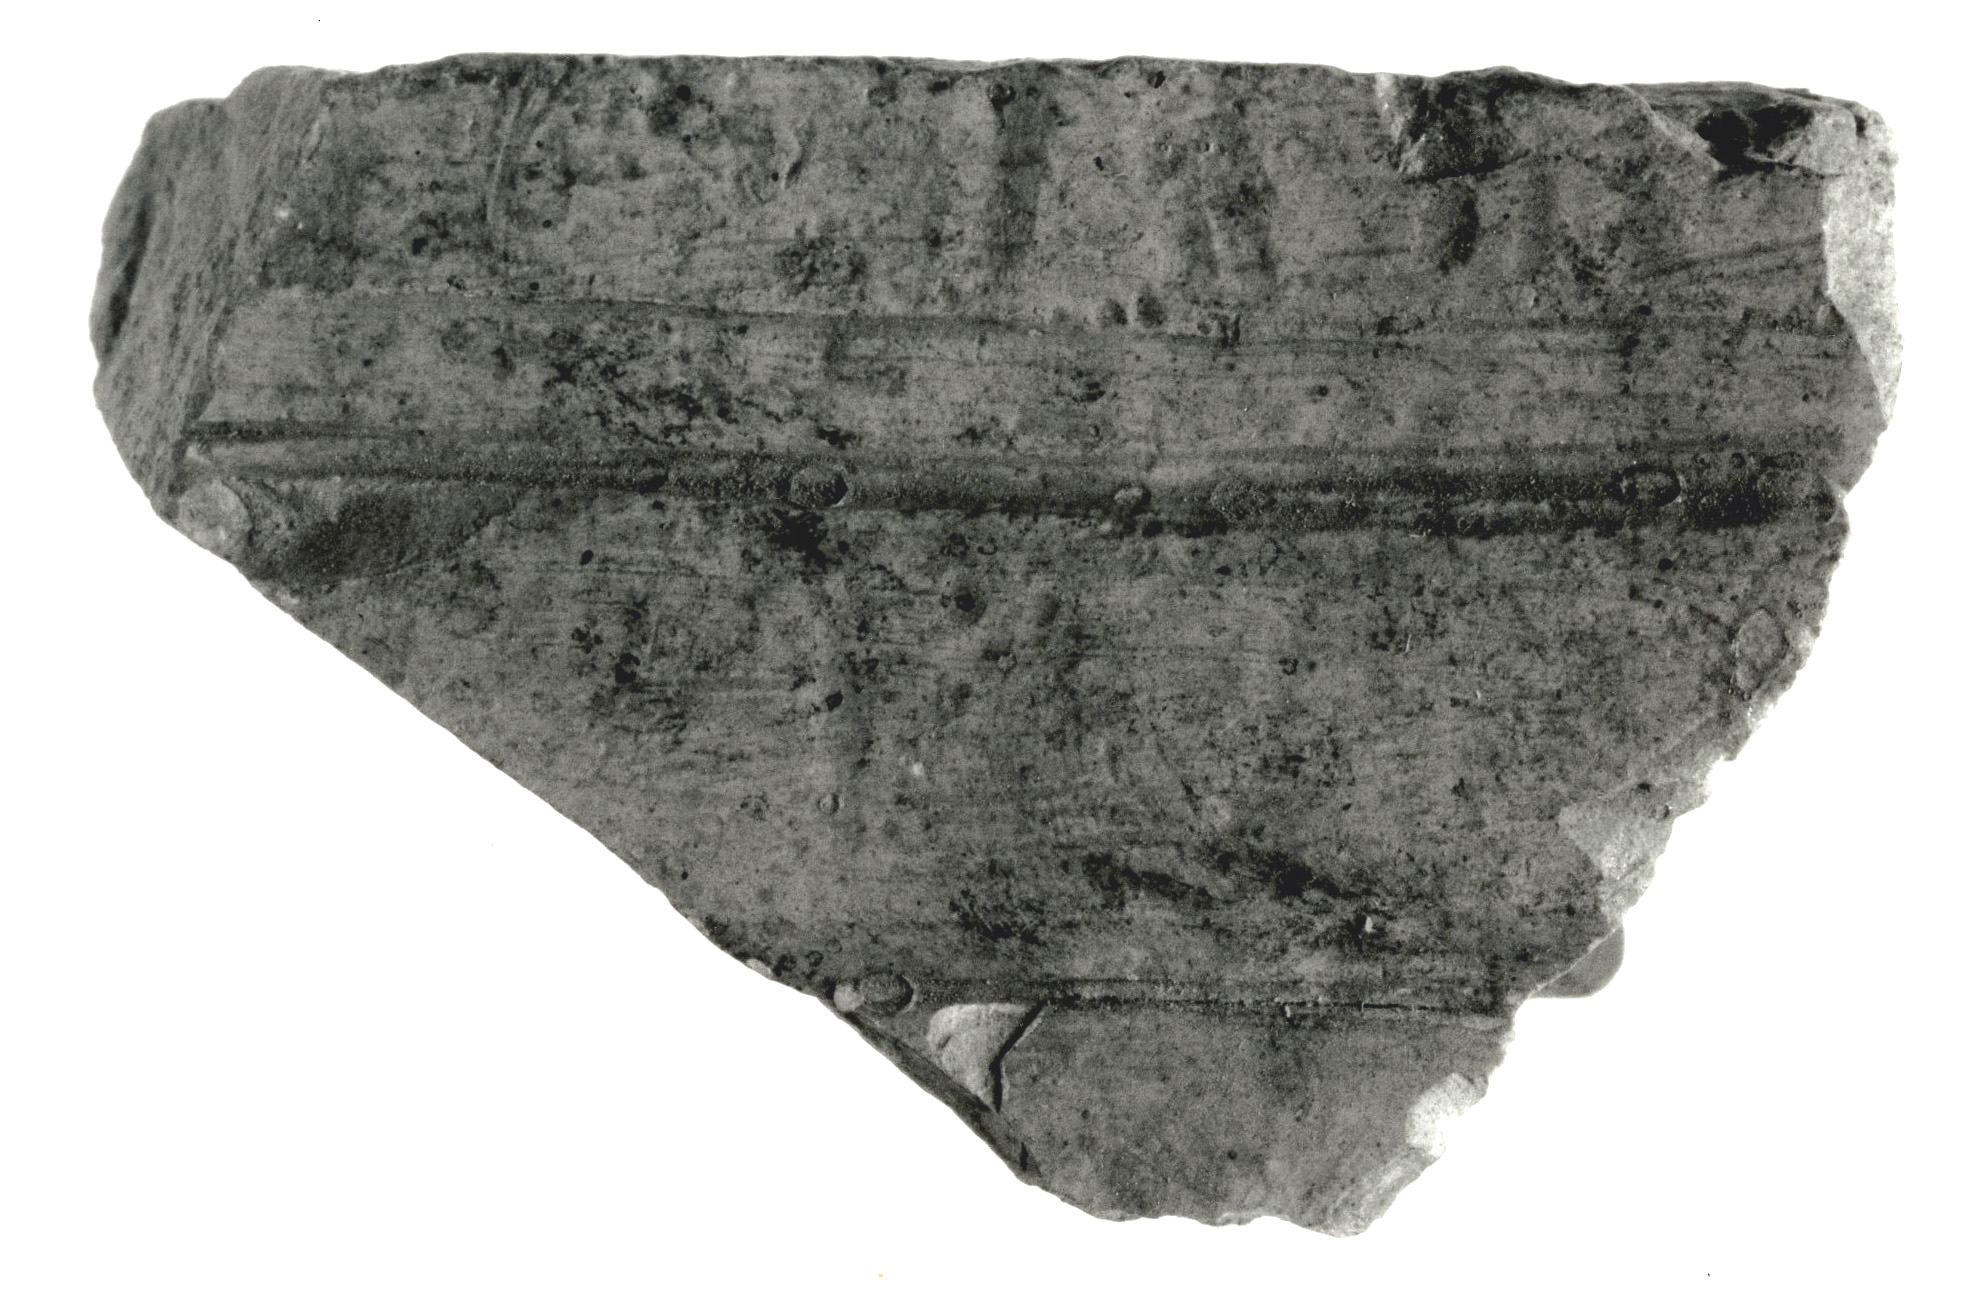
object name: relief, tomb of nespekashuty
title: Raised relief fragment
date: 664-610 BCE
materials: limestone, varnish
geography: egypt